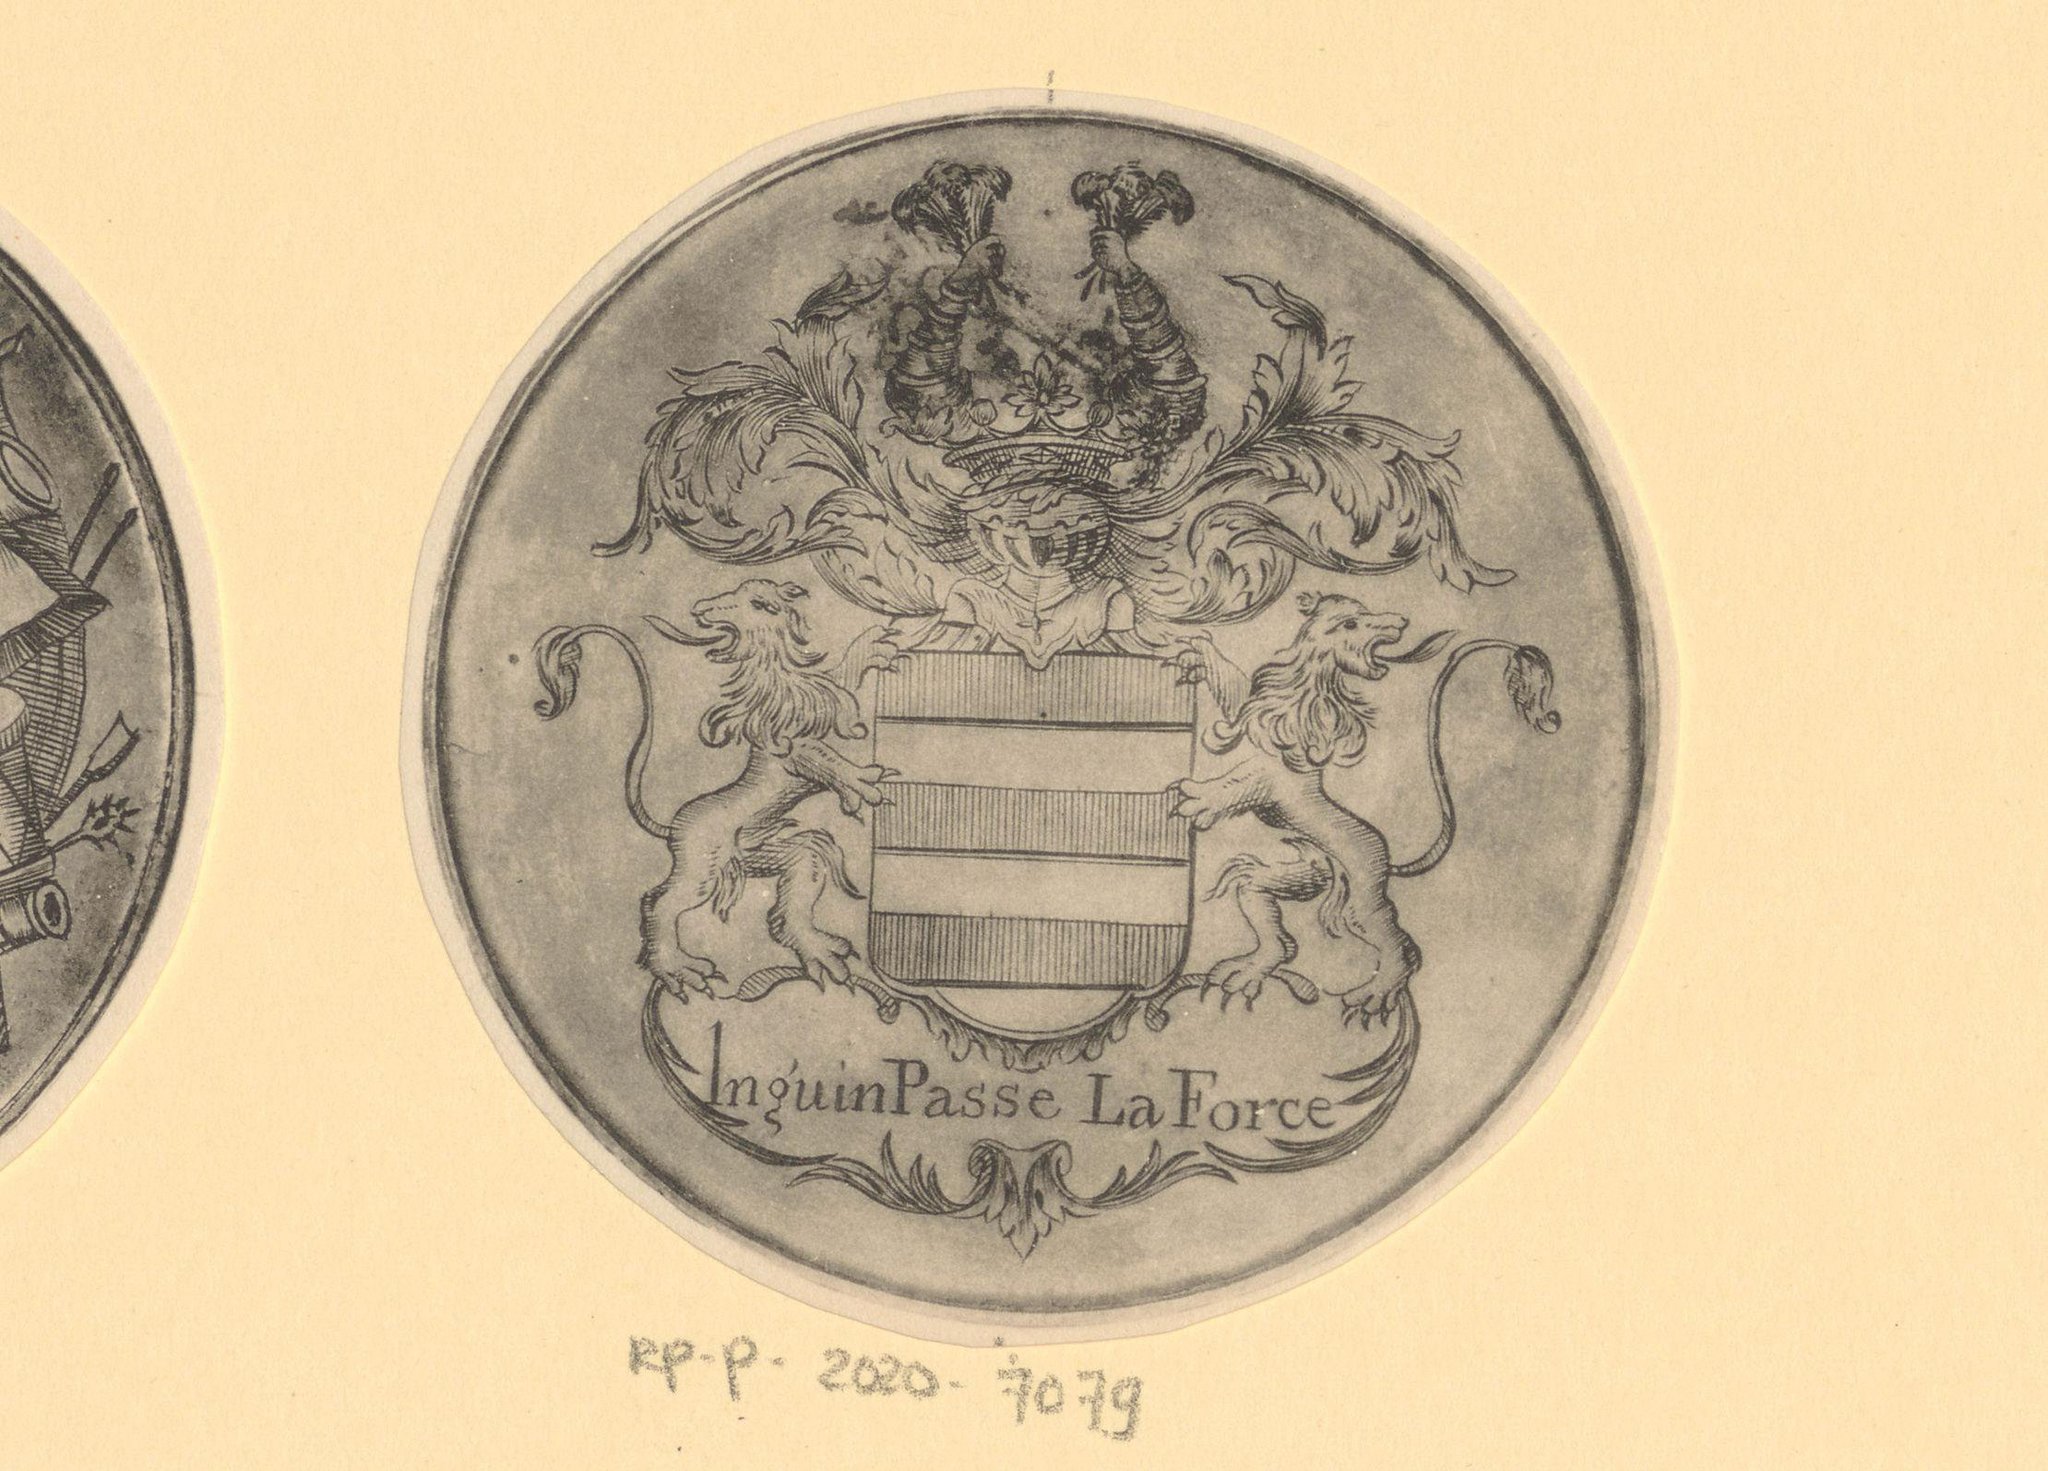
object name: photomechanical print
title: Ontwerp voor een gedenkpenning voor Hendrik Gravé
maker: Anonymous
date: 1900-1940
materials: paper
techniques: photograph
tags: amsterdam, commander-in-chief, general, marshal, historical persons, memorial medal